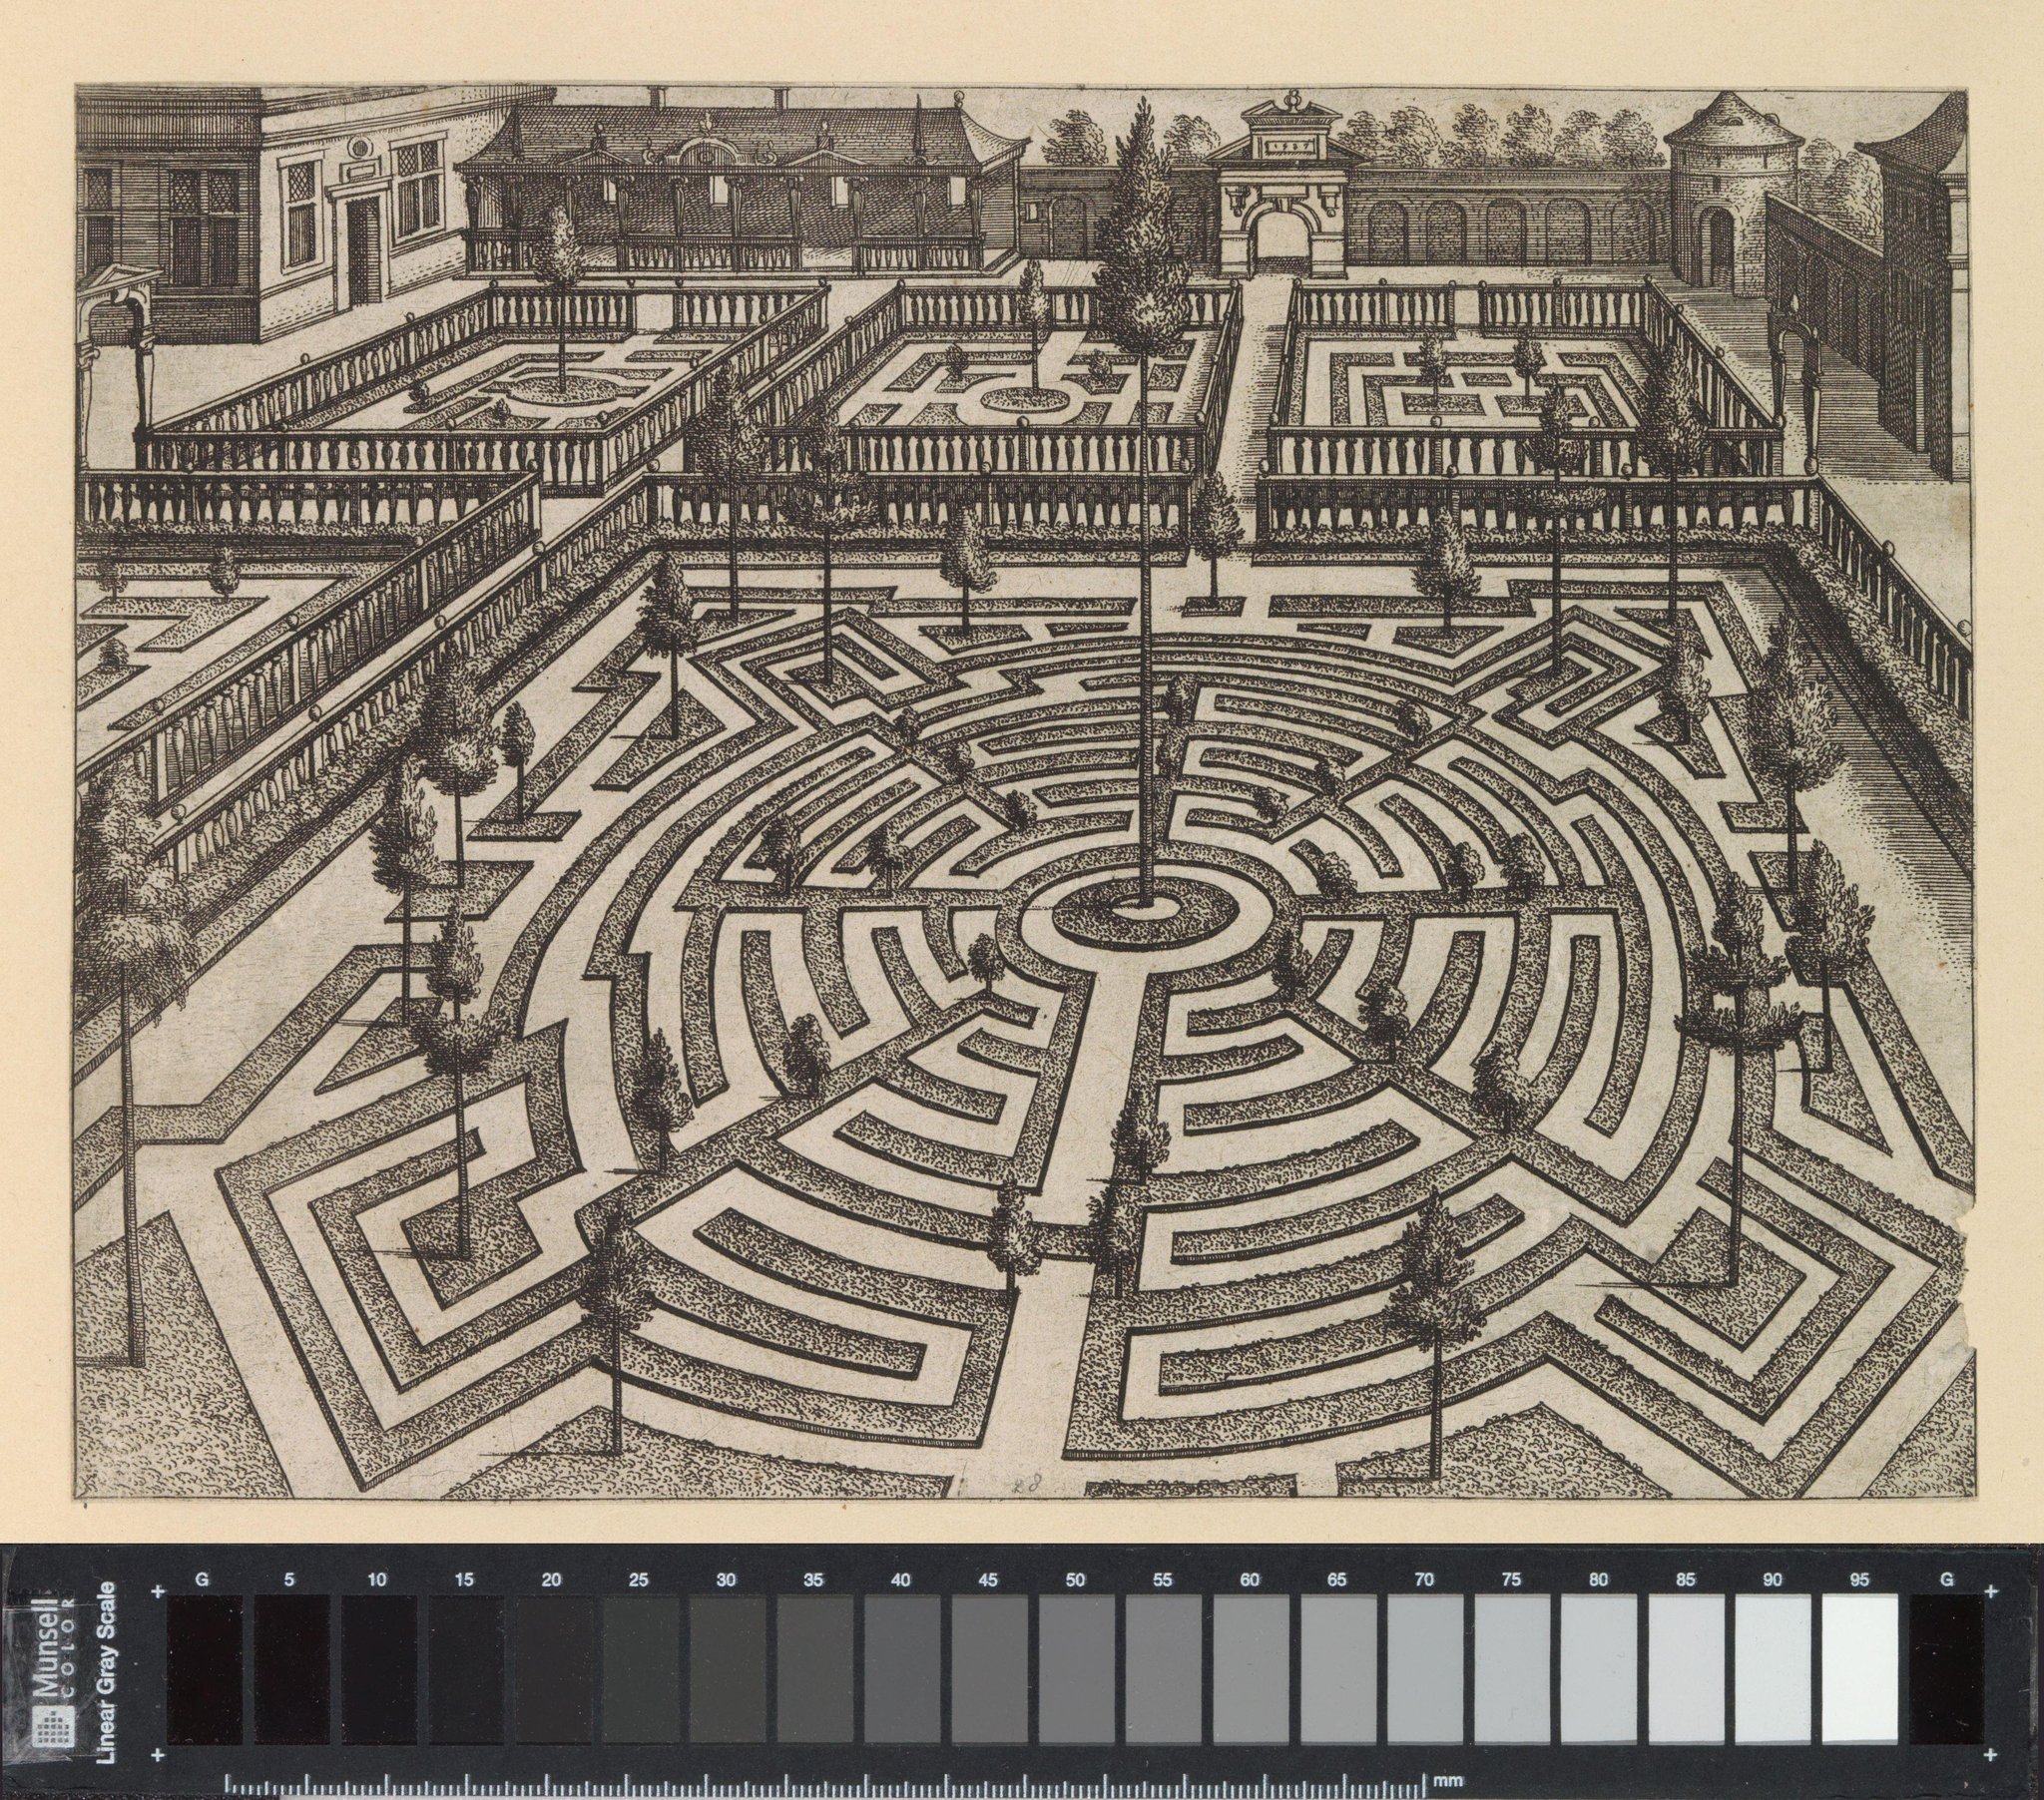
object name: print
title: Tuin met grote ronde parterre en vier kleinere perken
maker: Anonymous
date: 1587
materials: paper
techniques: etching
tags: garden, labyrinth, maze ~ garden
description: Tuin met ronde parterre, omgeven door een balustrade. Ernaast liggen vier met balustrades omgeven perken. De prent maakt deel uit van een album.